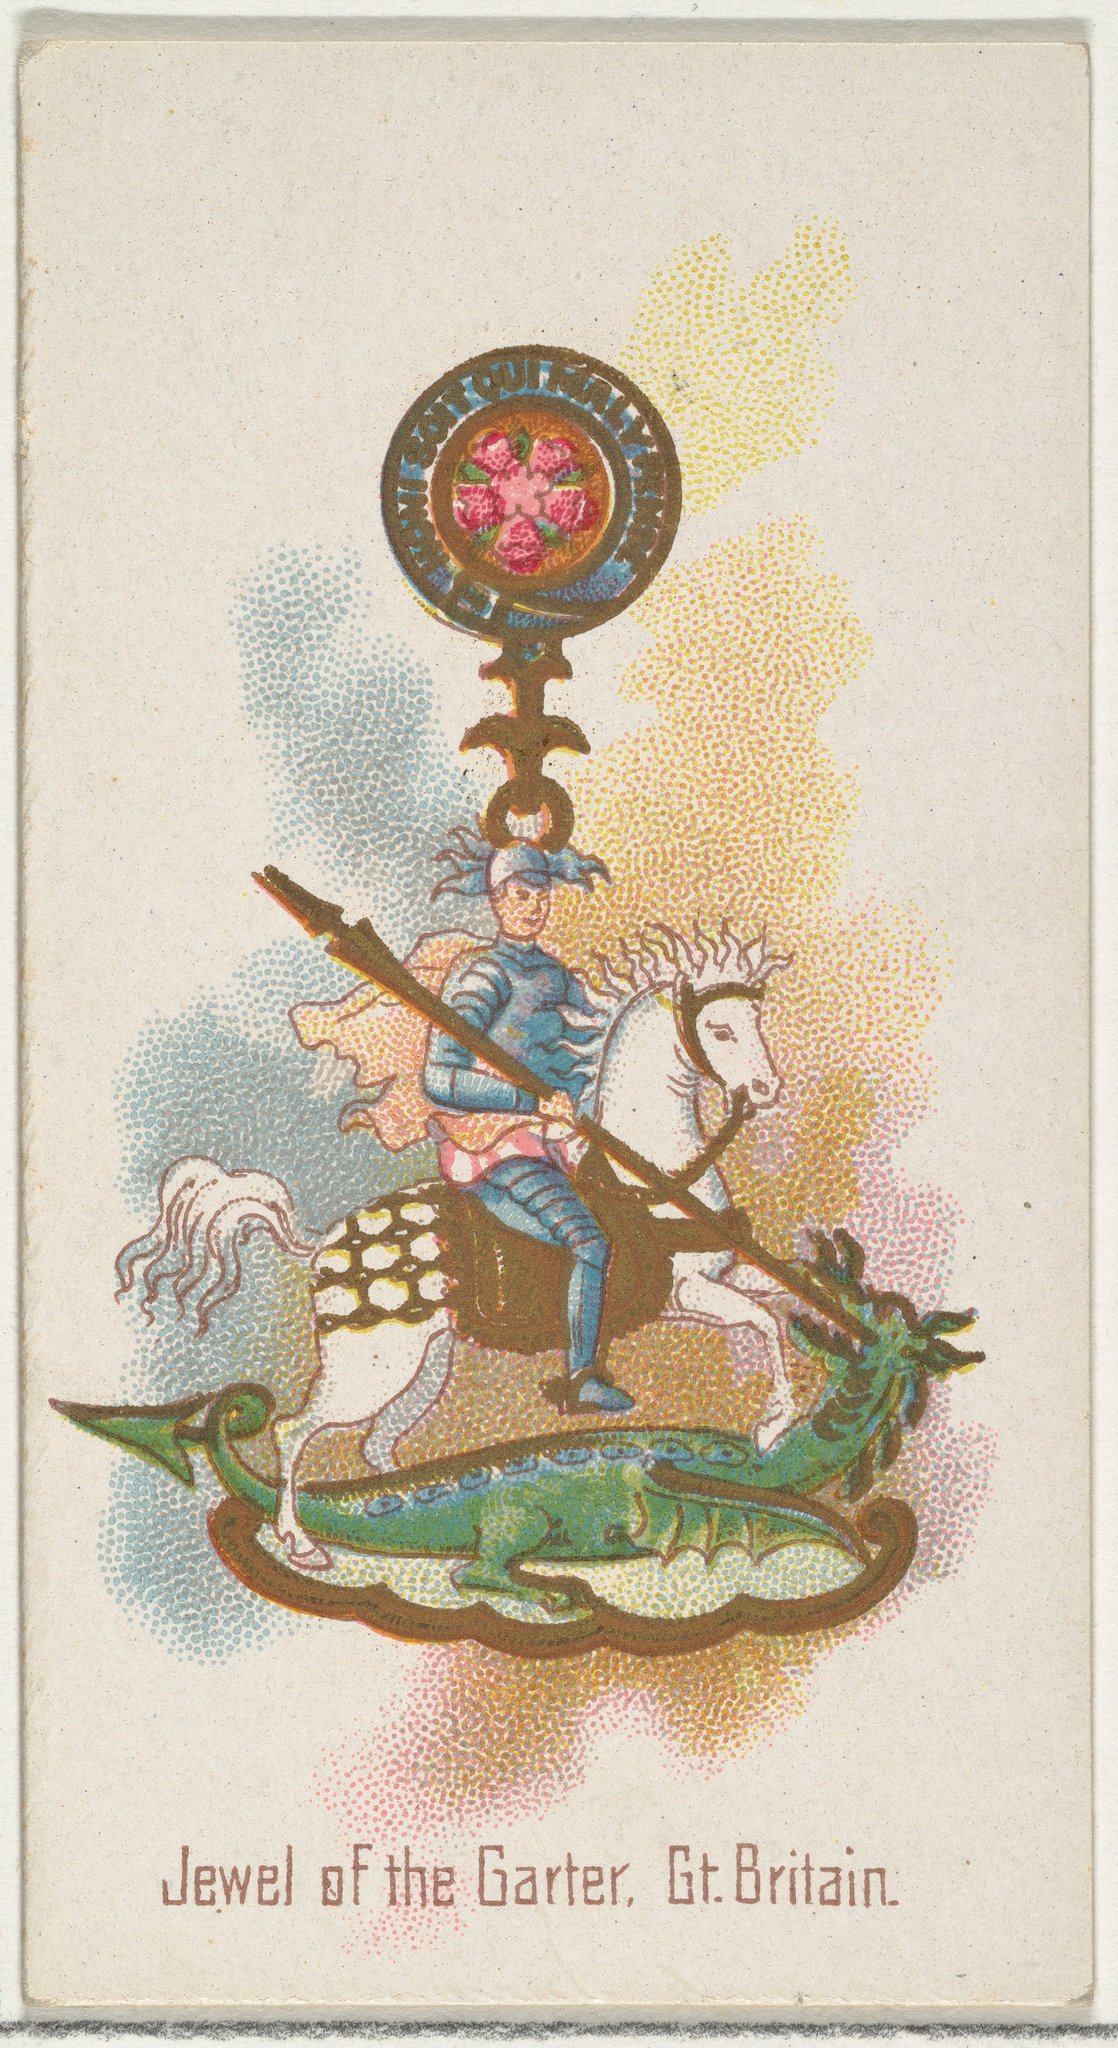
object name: print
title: Jewel of the Garter, Great Britain, from the World's Decorations series (N30) for Allen & Ginter Cigarettes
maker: allen & ginter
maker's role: publisher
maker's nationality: american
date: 1890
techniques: color lithograph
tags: dragons,horses,medals